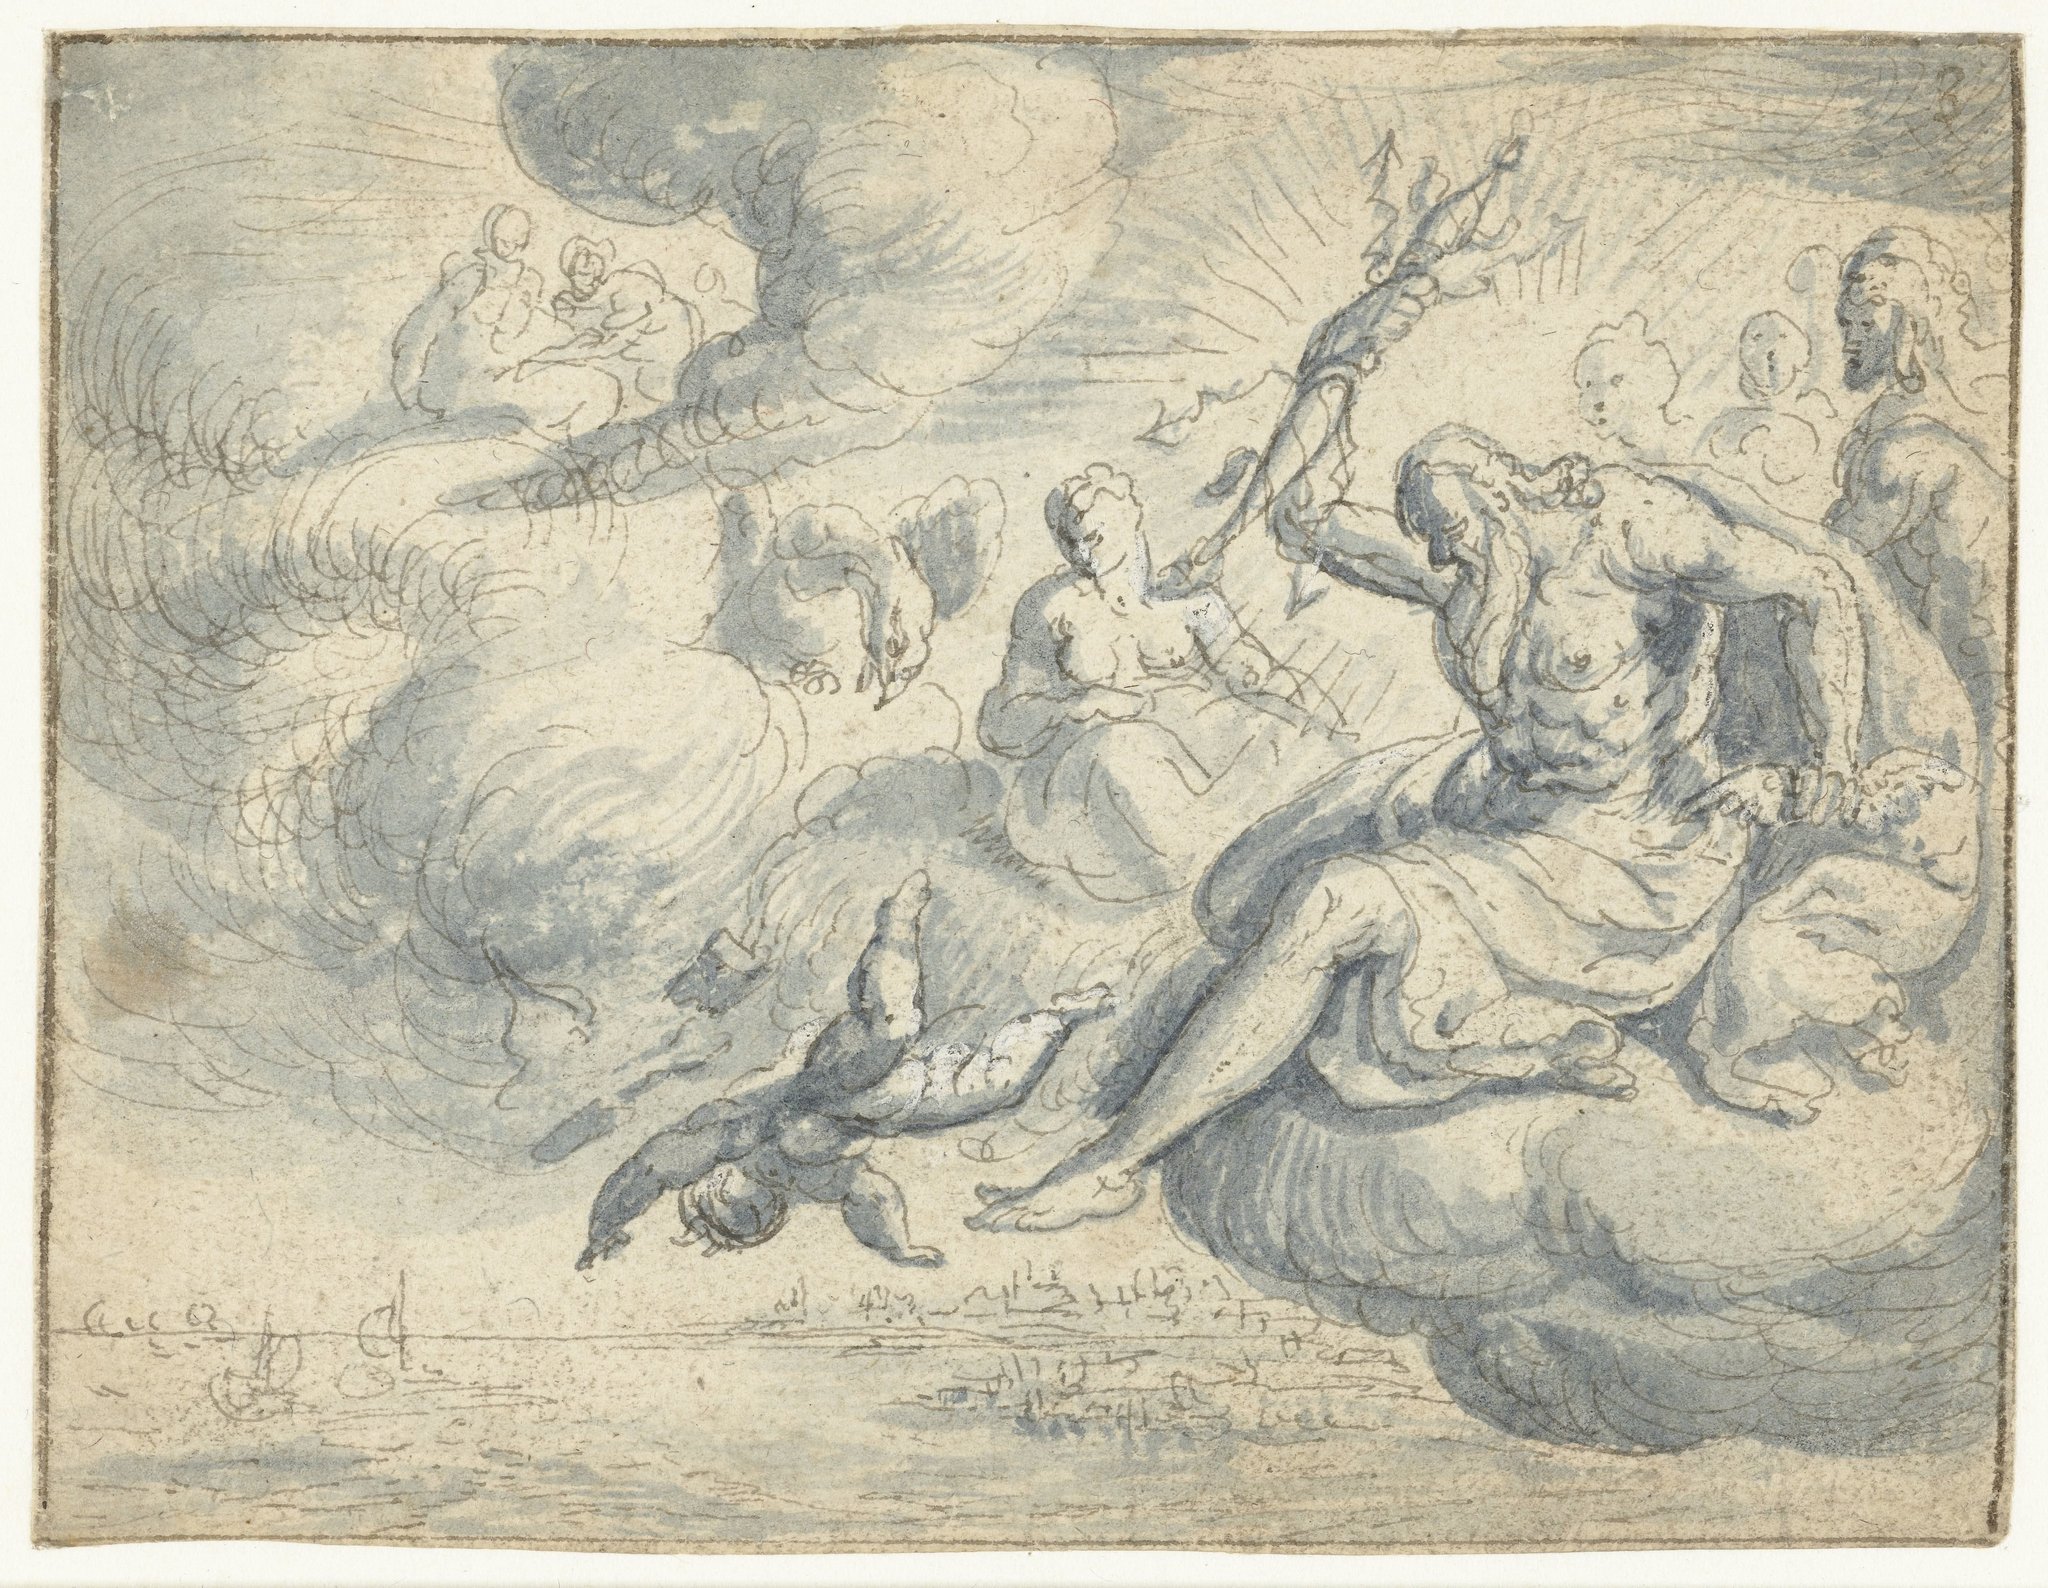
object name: drawing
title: Jupiter verbant Cupido uit de hemel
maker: jan snellinck (i)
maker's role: draughtsman, painter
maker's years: 1544-1638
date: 1575-1580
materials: ink, paint, paper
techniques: brush, pen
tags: suffering, misfortune of cupid, (story of) jupiter (zeus)